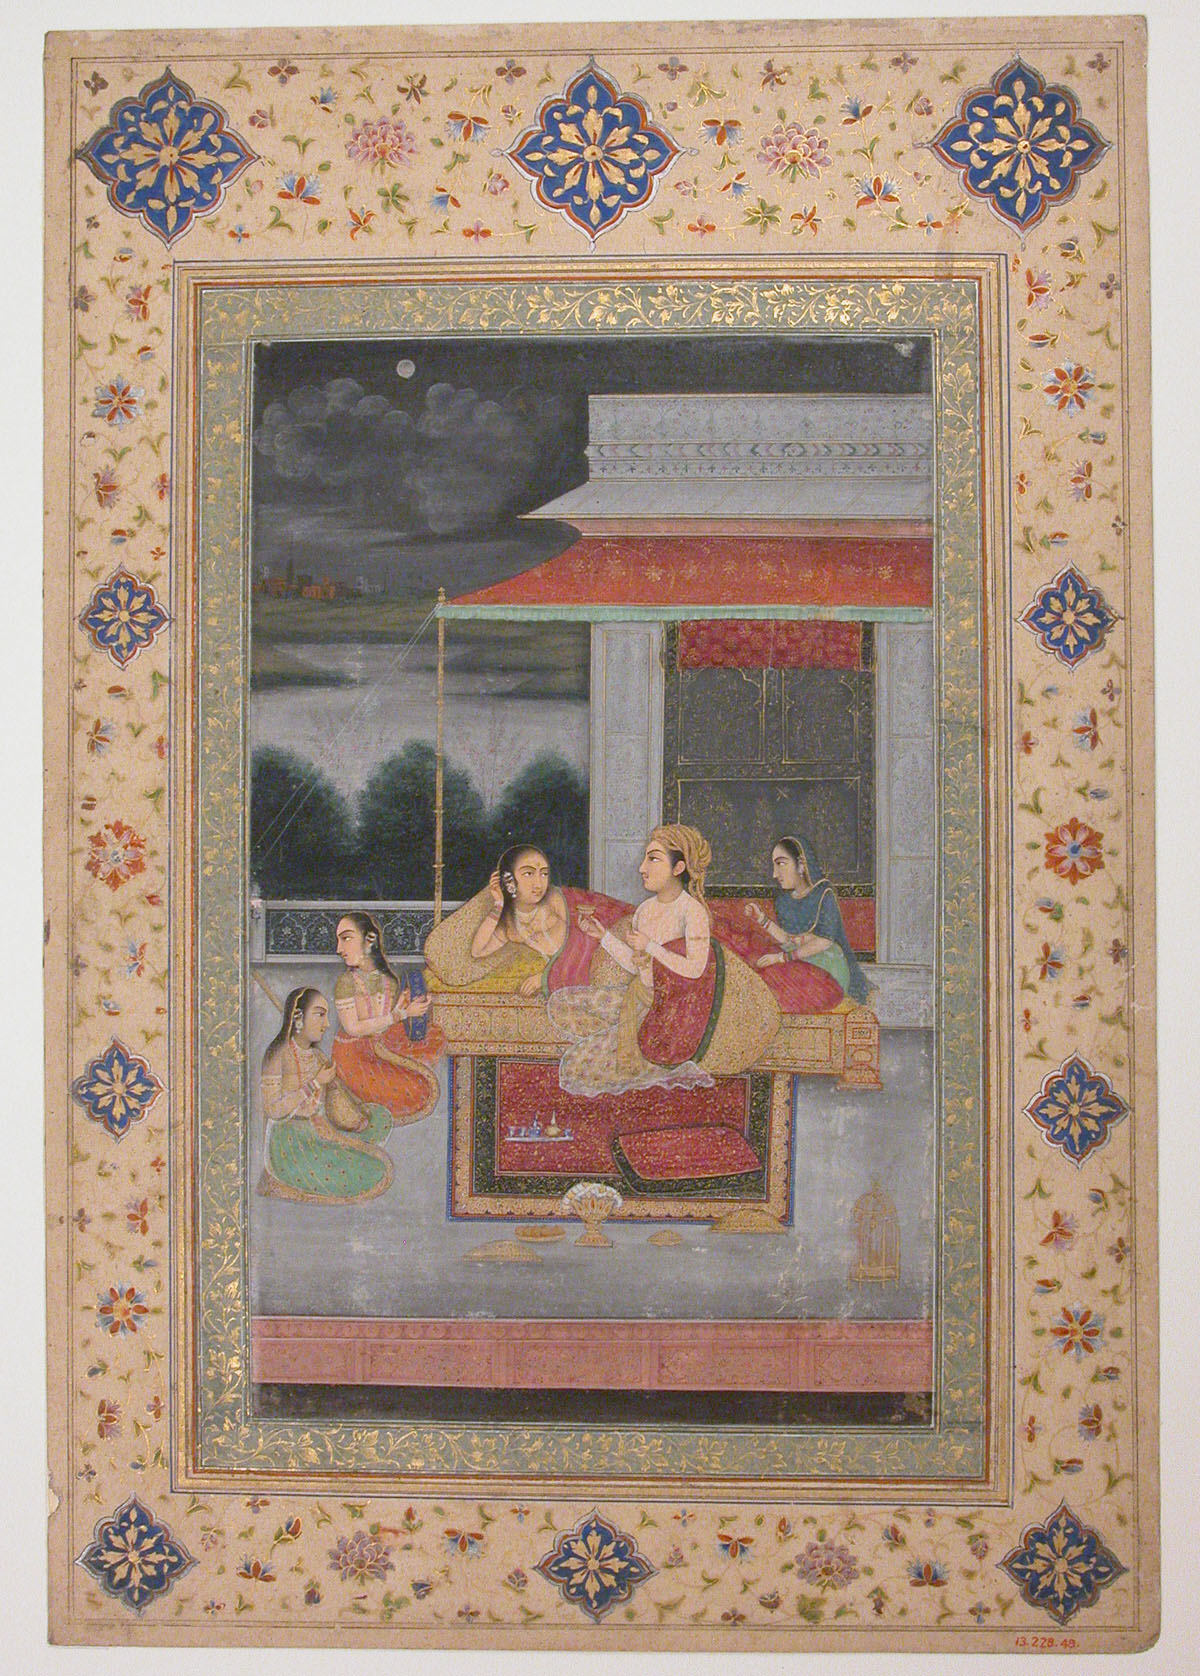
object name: album leaf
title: Entertainment on a Terrace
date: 1601-1700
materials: gold, ink, paper, watercolor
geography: india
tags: roofs,women,entertainment